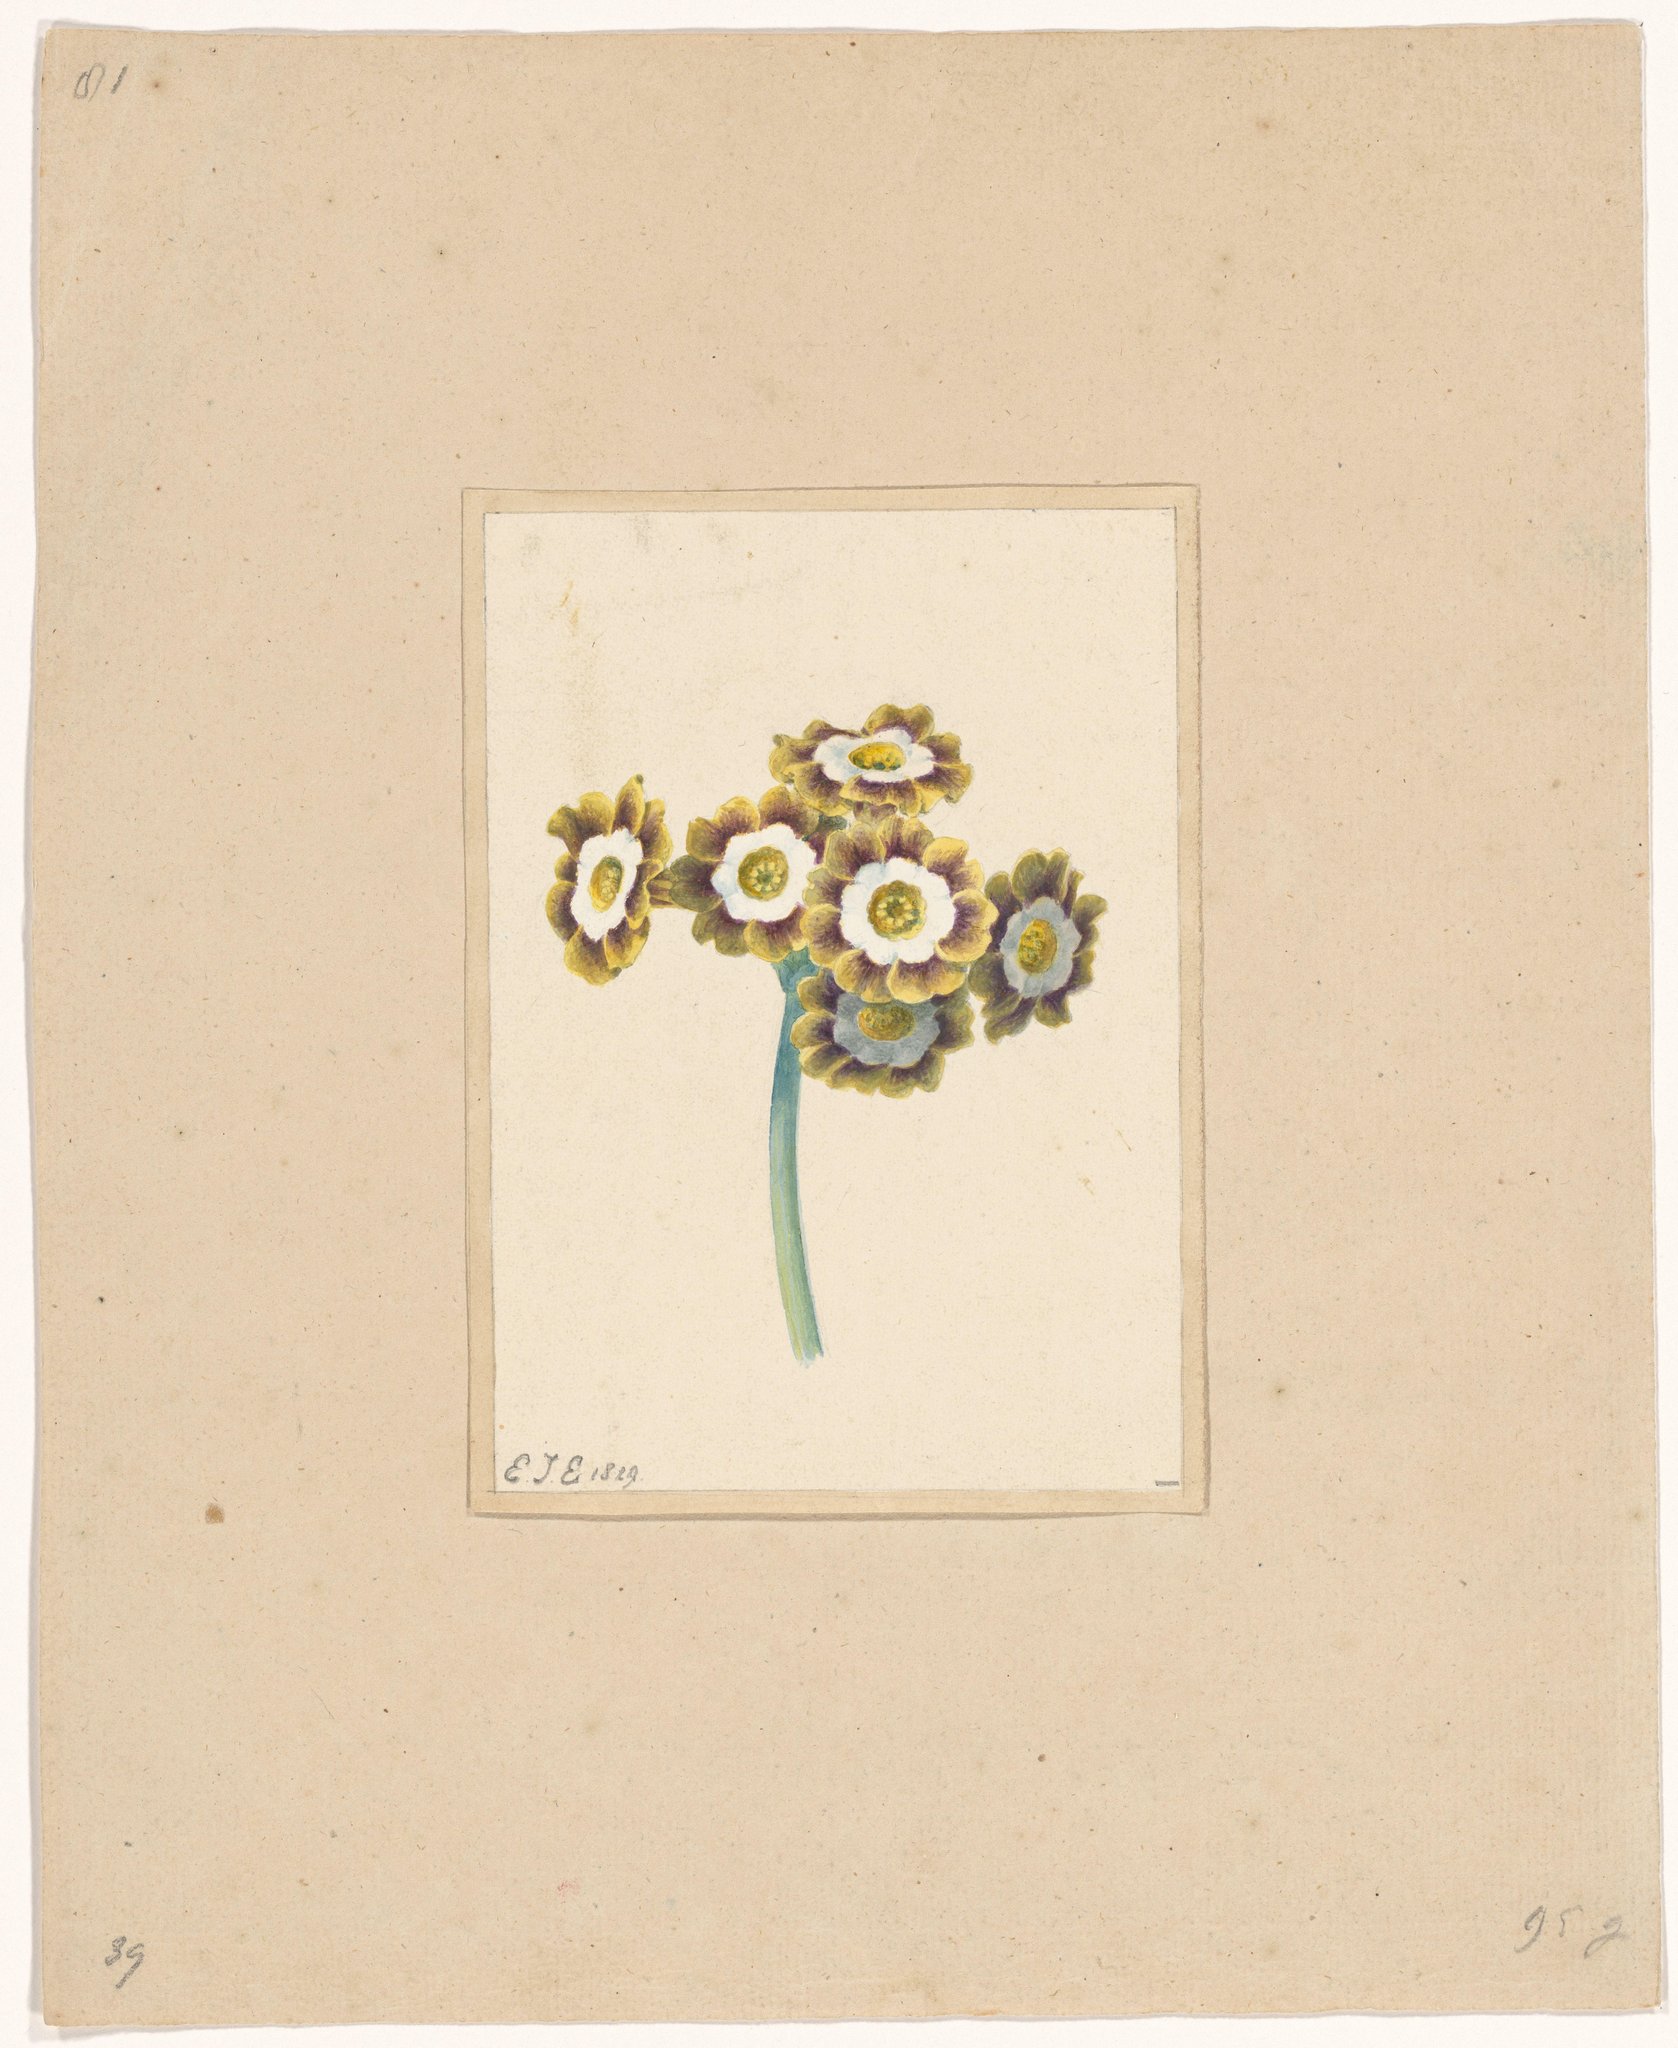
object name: drawing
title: Primula auricula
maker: Anonymous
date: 1815-1830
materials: paper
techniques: drawing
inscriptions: inscription: ‘EJE 1829’